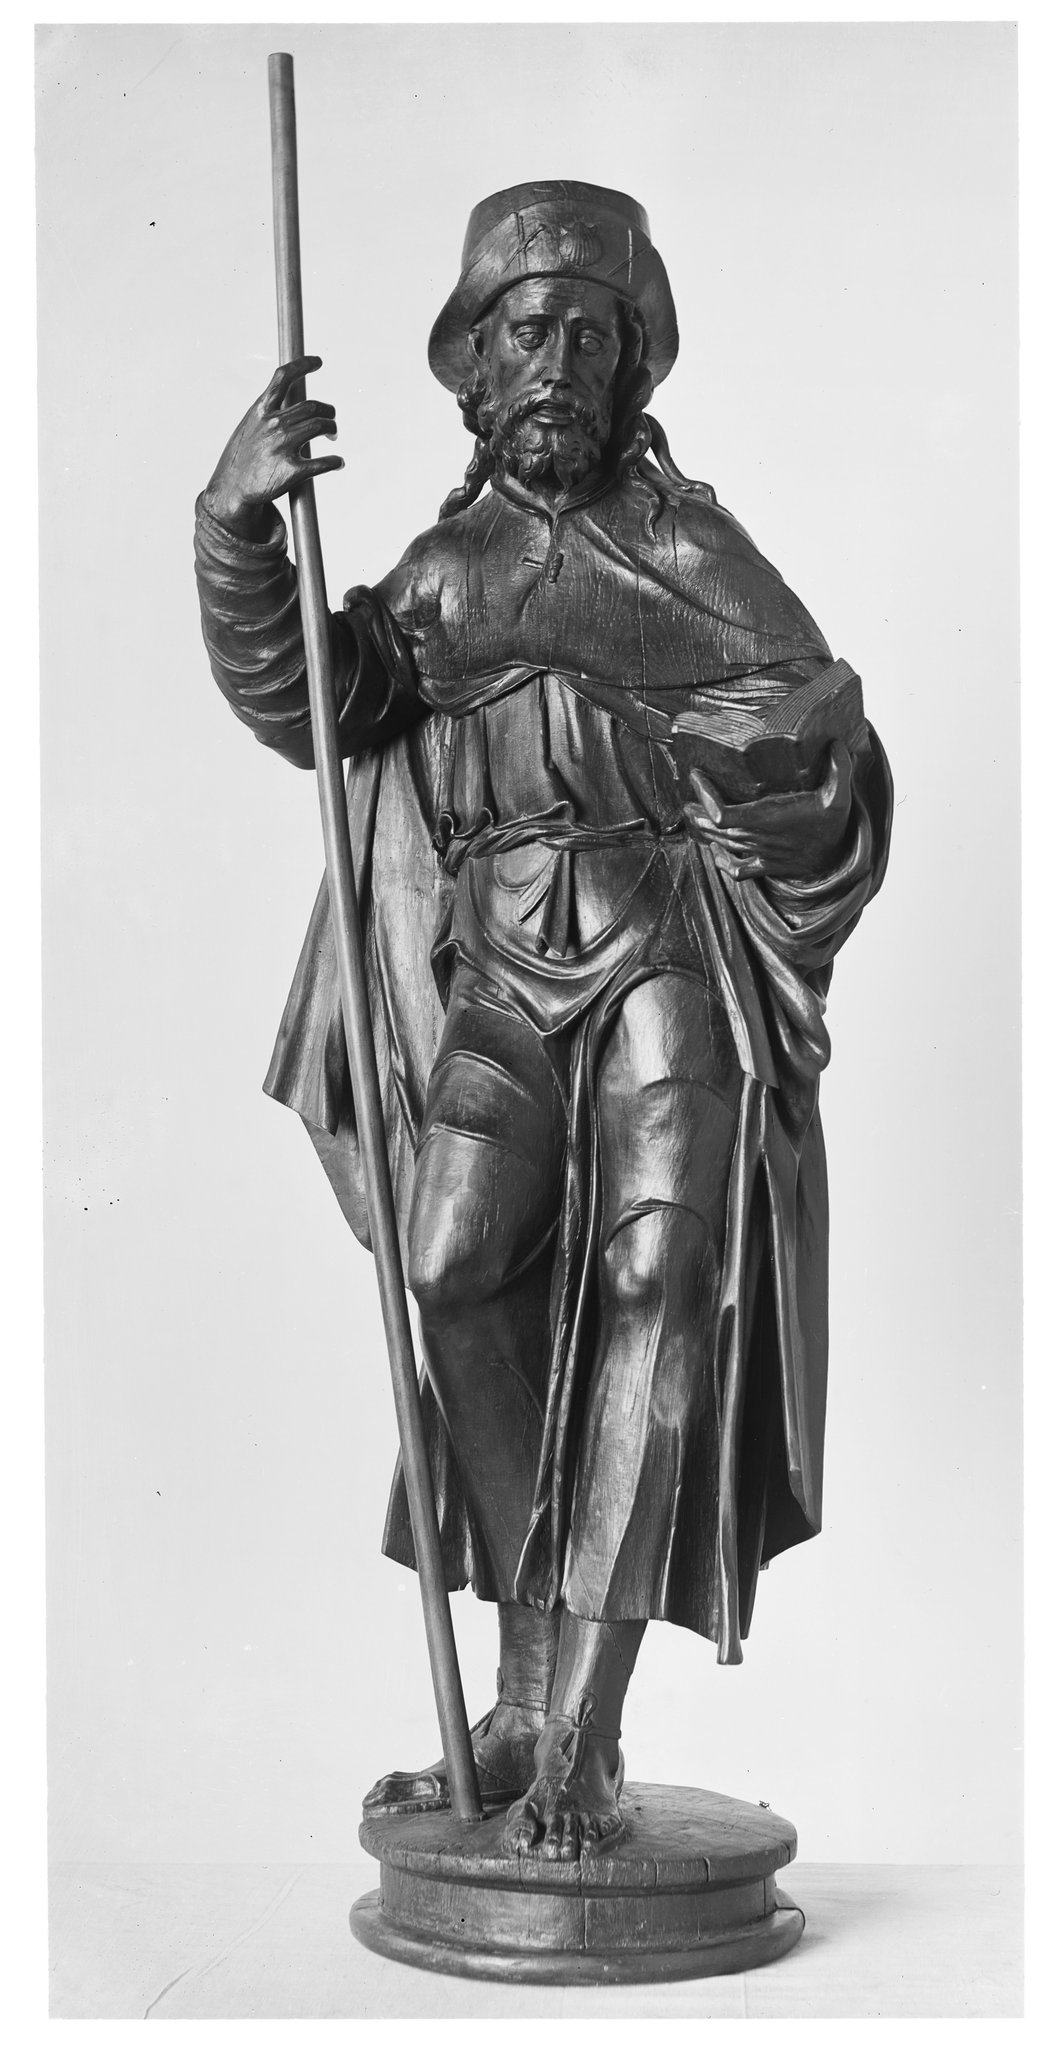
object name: statue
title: Saint James the Great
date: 1534-1566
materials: wood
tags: men,saints